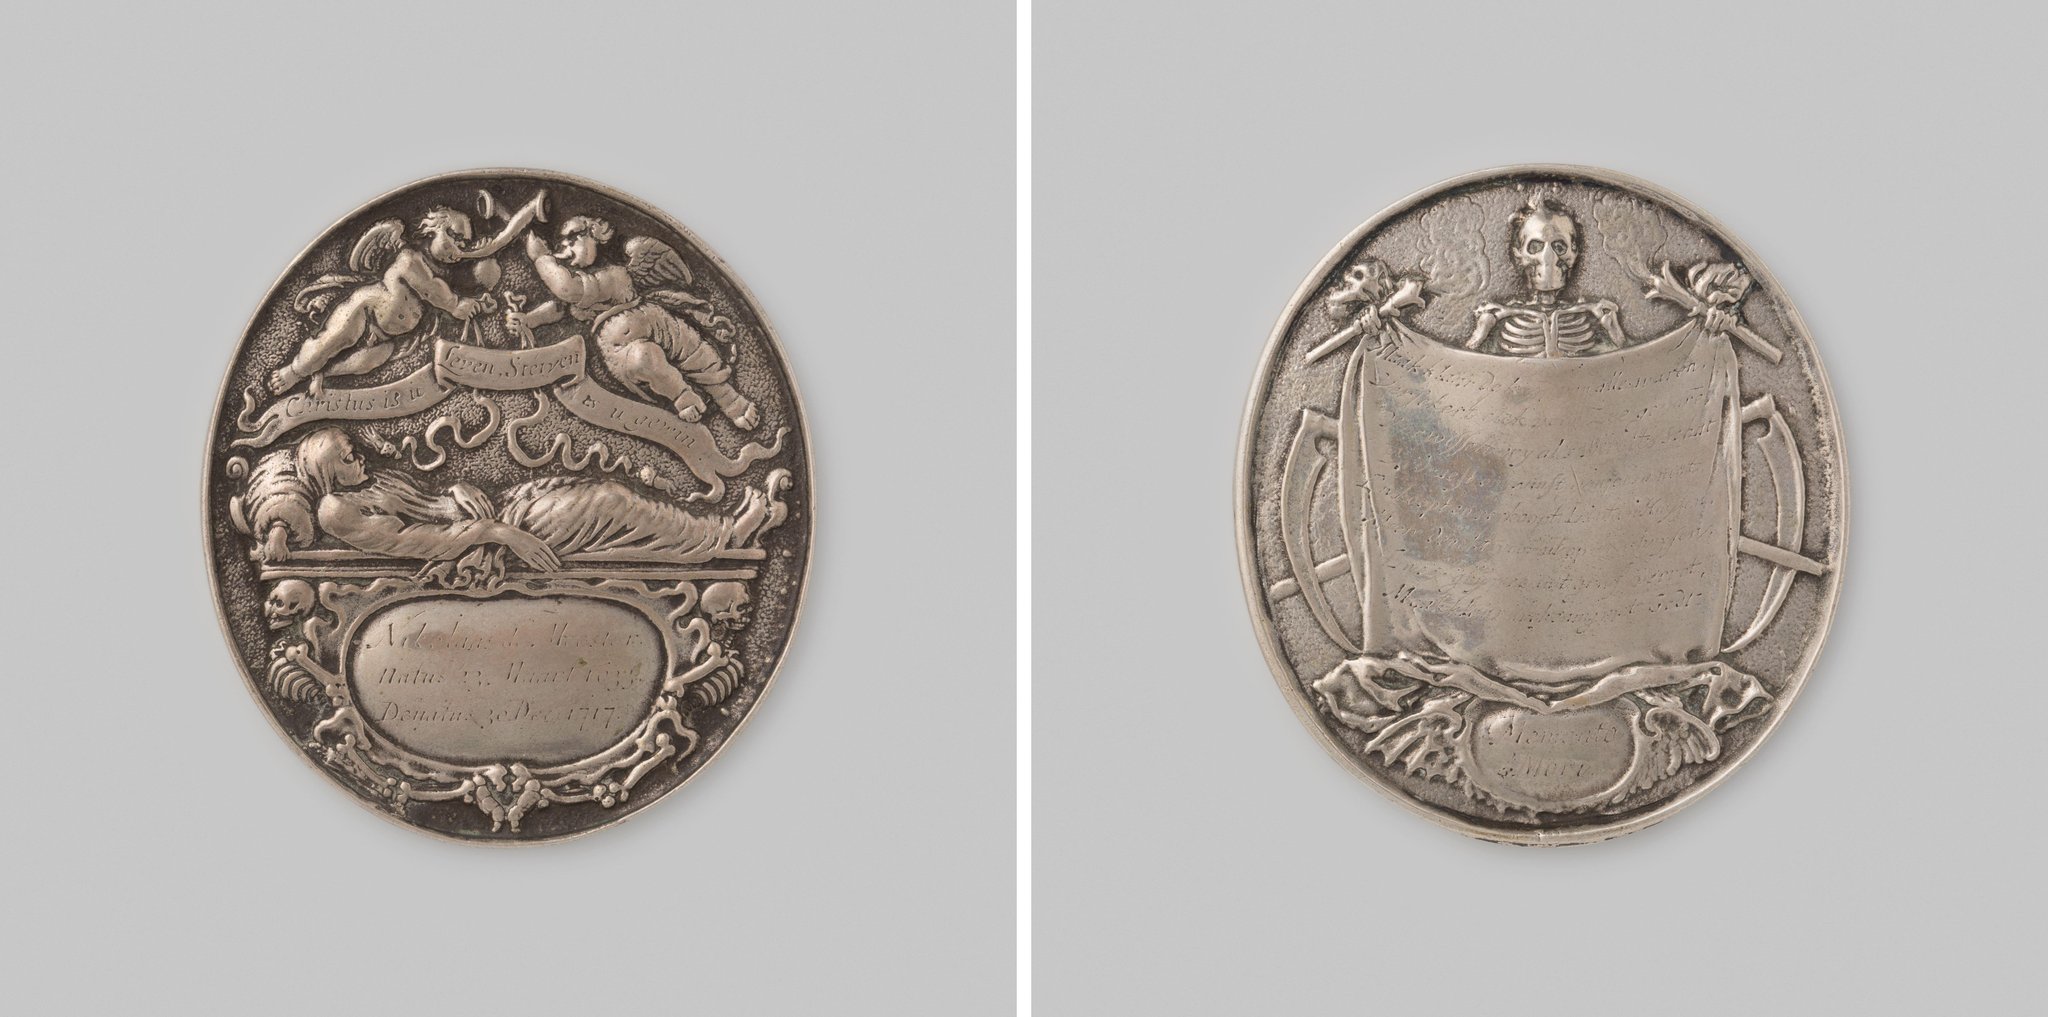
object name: family medal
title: Begrafenispenning van Nicolaas de Meester 1717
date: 1717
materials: silver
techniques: casting, engraving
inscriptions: inscription: ‘Memento / Mori’, inscription: ‘Nicolaus den Meester / natus 23 Maart 1633 / Denatus 30 Dec 1717’, inscription: ‘Christus is u - leven. Sterven - is u gewin.’, inscription: ‘Maak klaar de koop van alle waren, / Versekert elck van zee gevare' / Verwisselt vry al 's werelts schat / En draeft om winst (...) / En koopt en verkoopt lant en huysen, / Maer denckt vooral op (...)huysen / En eer ghy mee in't graf verrot, / Maak klaar u rekening met Godt:’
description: Gegoten ovale zilveren penning, op de voorzijde een overledene naar links op een baar, waaronder een ovale inscriptieruimte tussen twee skeletten, bovenaan twee bazuinblazende engelen met een lint met opschrift, alles op gepointilleerd veld, op de keerzijde een staand skelet met twee zeisen en twee fakkels dat een beschreven doek ophoudt, waaronder nog een ovalen inscriptieruimte.